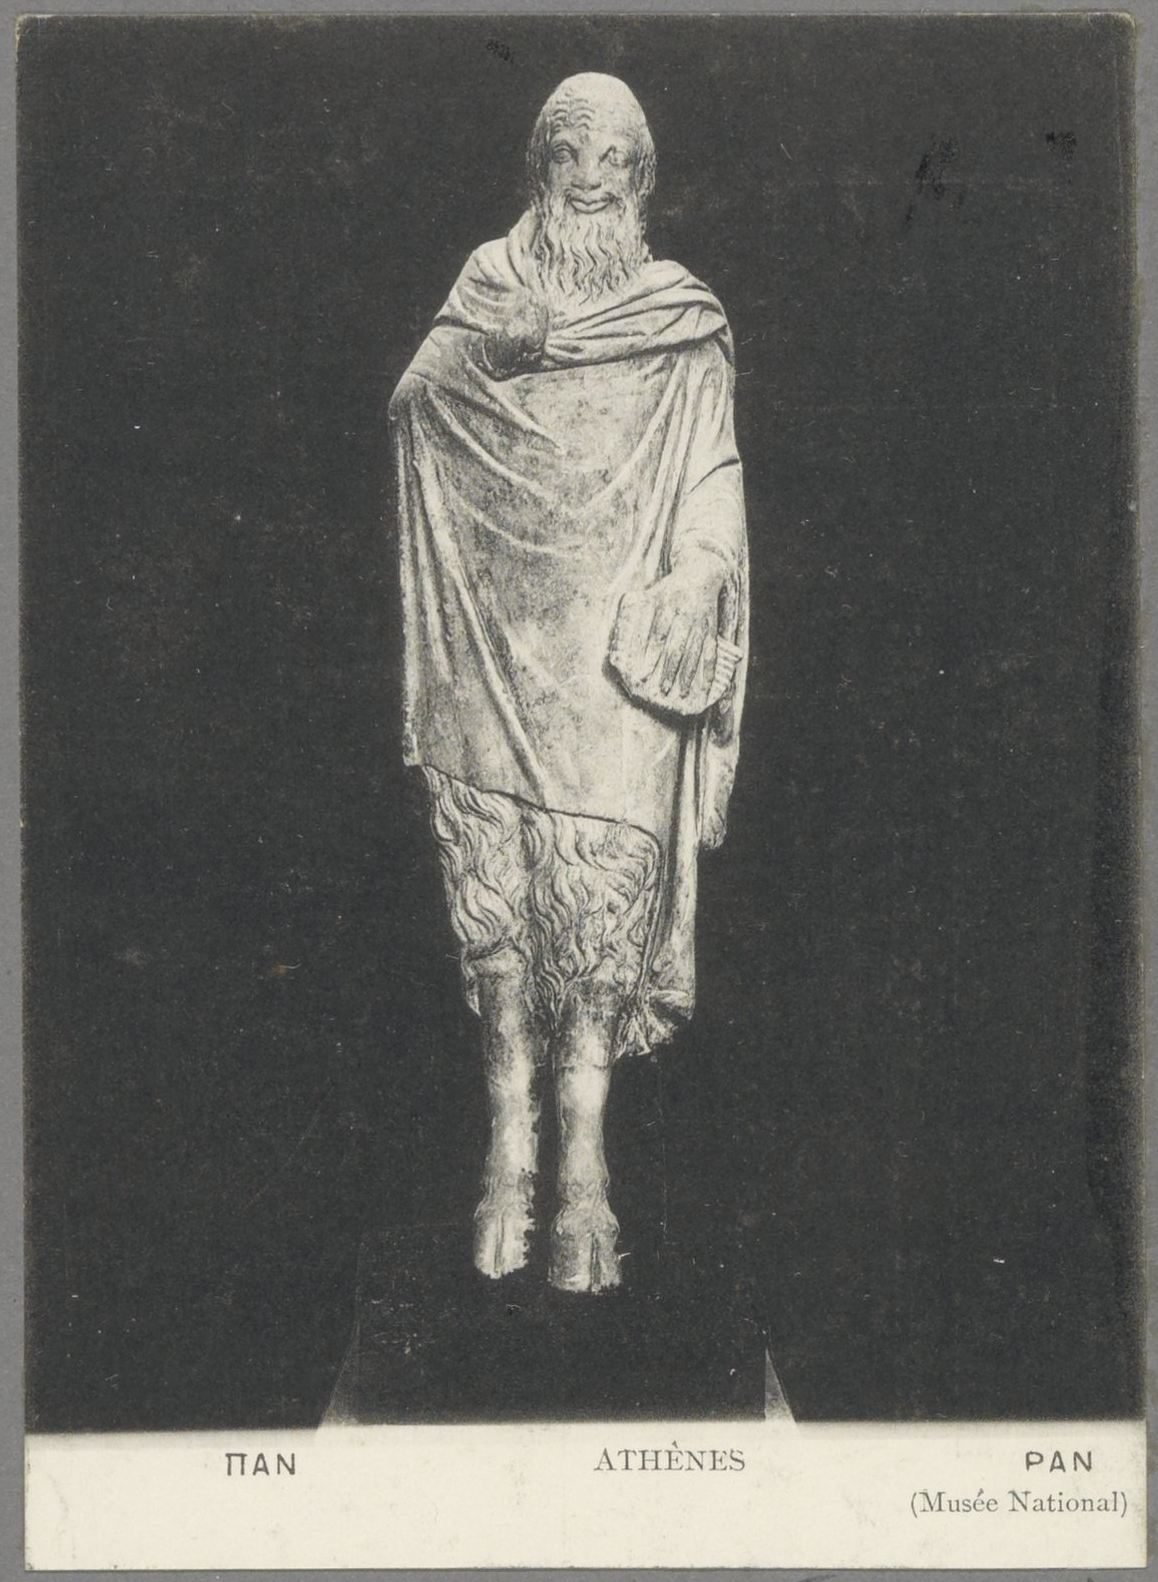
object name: ansichtkaart, prentbriefkaart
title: Beeld van Pan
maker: Anonymous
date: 1895-1905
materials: paper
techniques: photograph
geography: athens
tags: (story of) pan, piece of sculpture, reproduction of a piece of sculpture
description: Onderdeel van Reisalbum met foto's van bezienswaardigheden in Griekenland en Egypte.